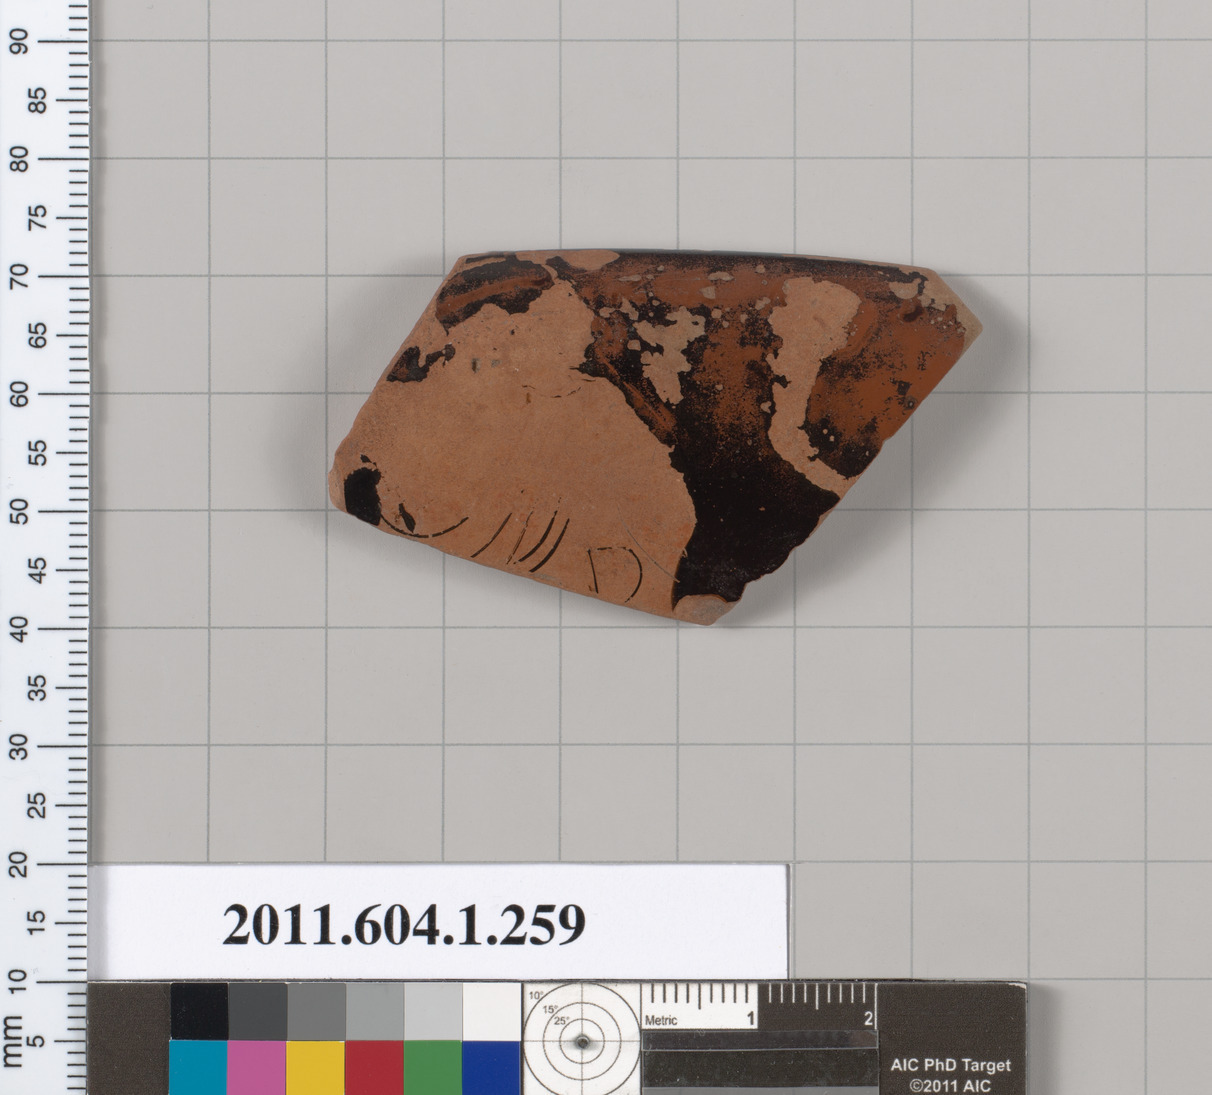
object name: kylix fragment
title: Terracotta rim fragment of a kylix (drinking cup)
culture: greek, attic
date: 475-451 BCE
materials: terracotta